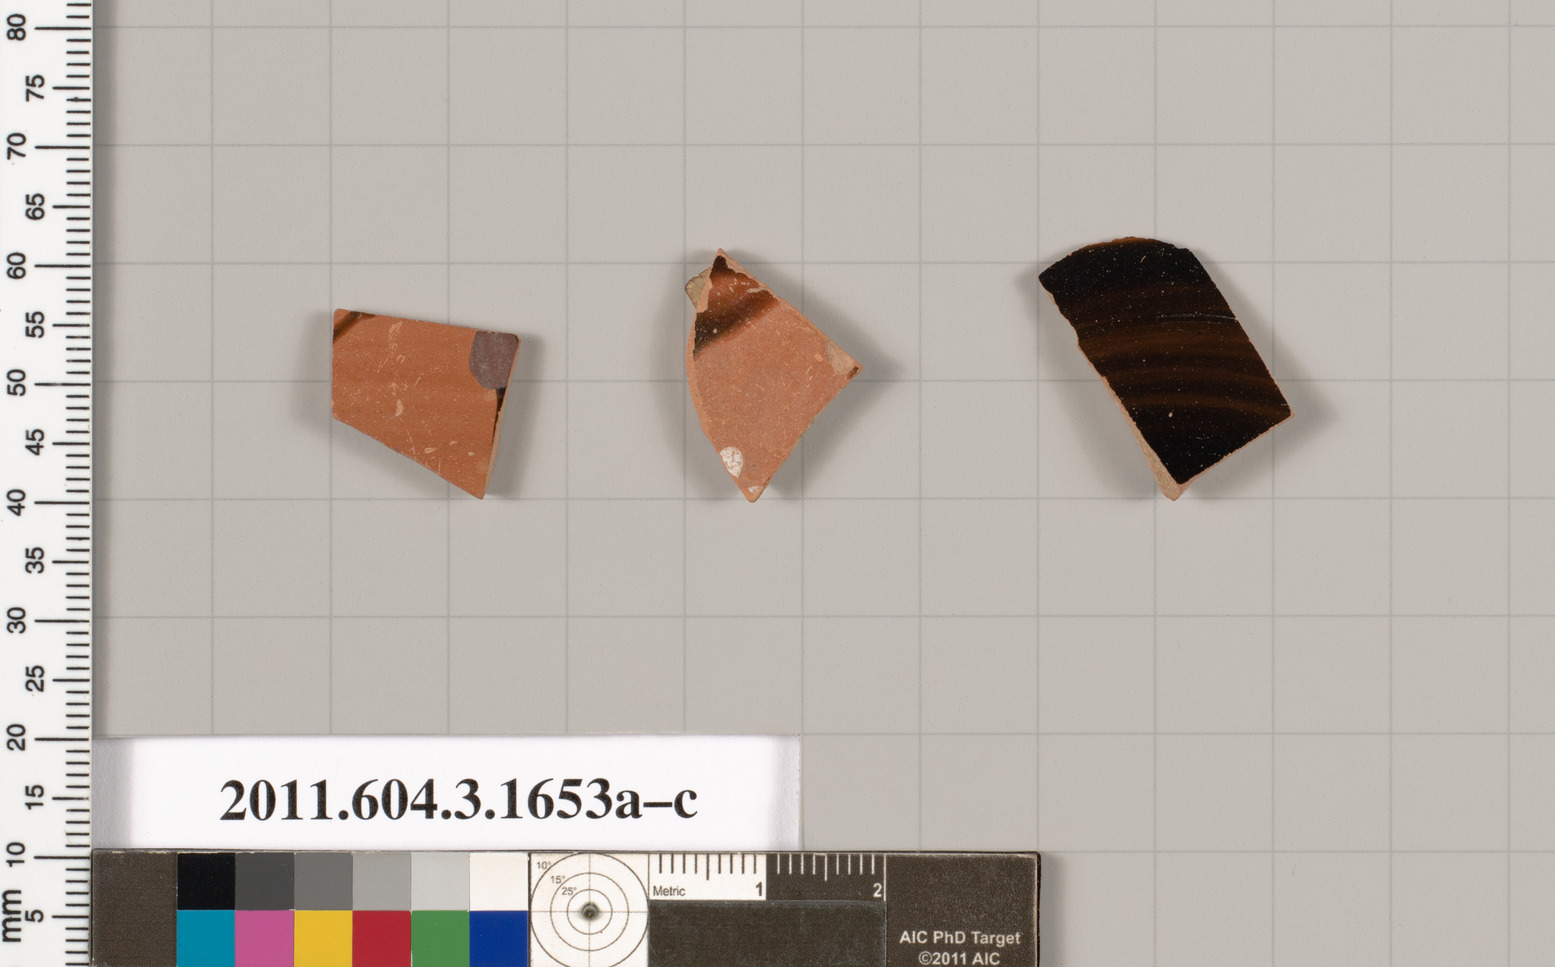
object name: kylix fragment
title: Terracotta fragments of kylikes: Band or lip cups (drinking cups)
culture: greek, attic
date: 550-526 BCE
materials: terracotta